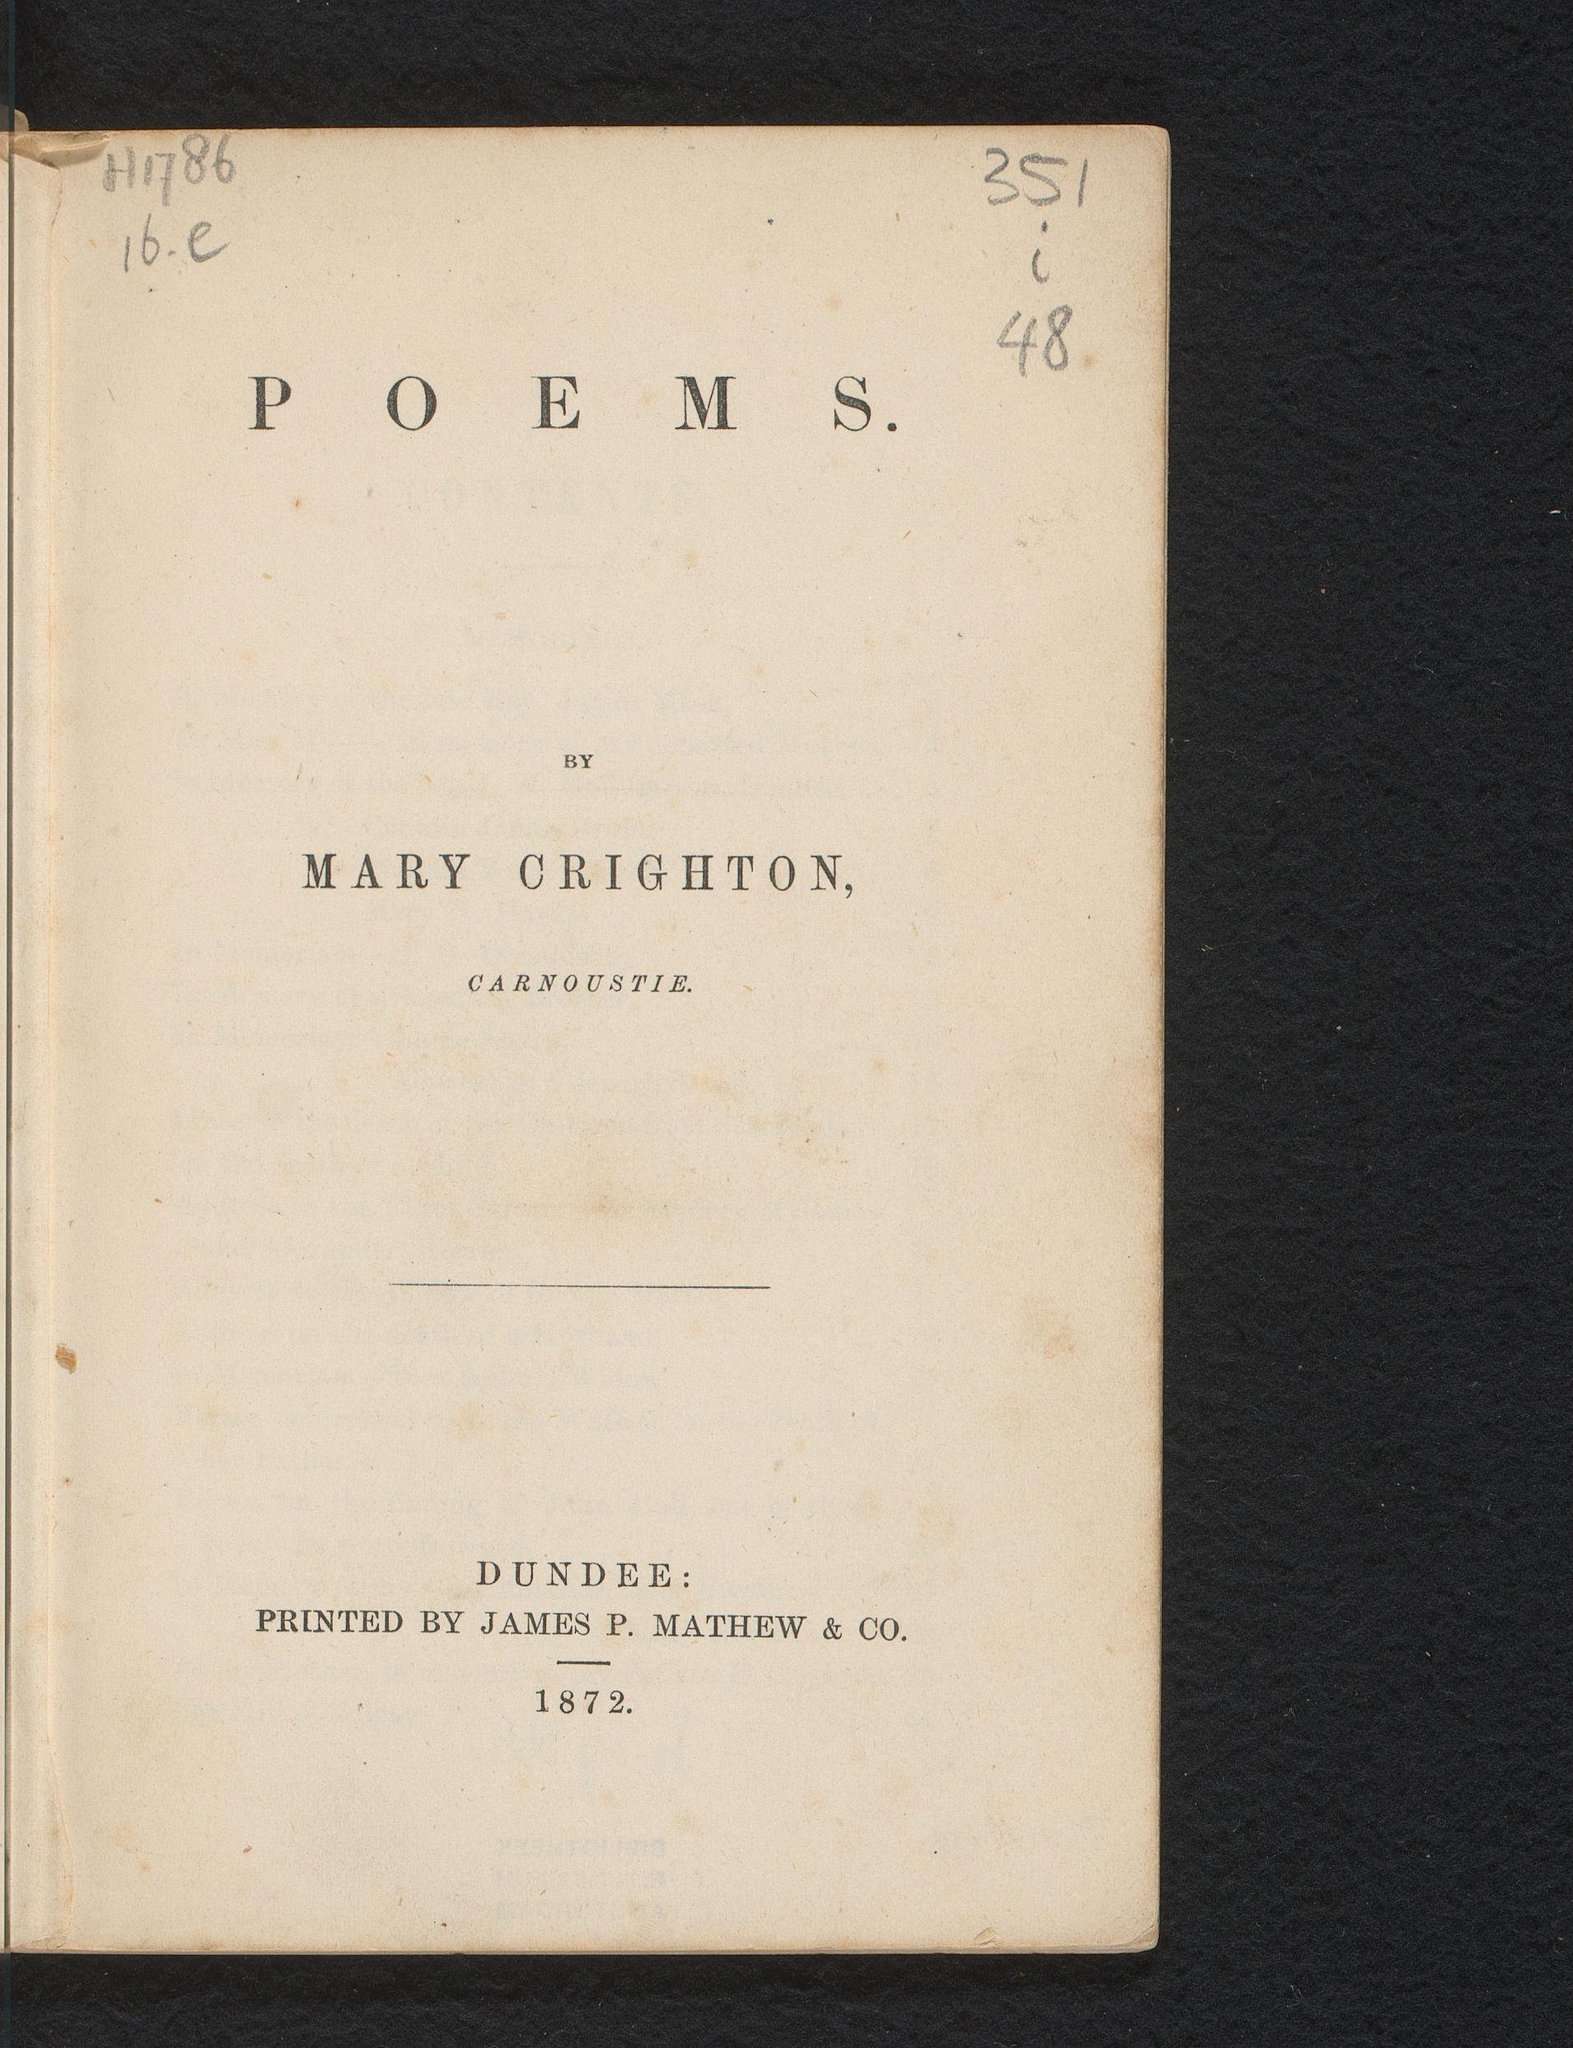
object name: book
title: Poems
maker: mary crighton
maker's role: dichteres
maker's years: 1850-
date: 1872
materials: cardboard, paper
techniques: albumen print, letterpress printing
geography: dundee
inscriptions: inscription: ‘[...] this book [...]’